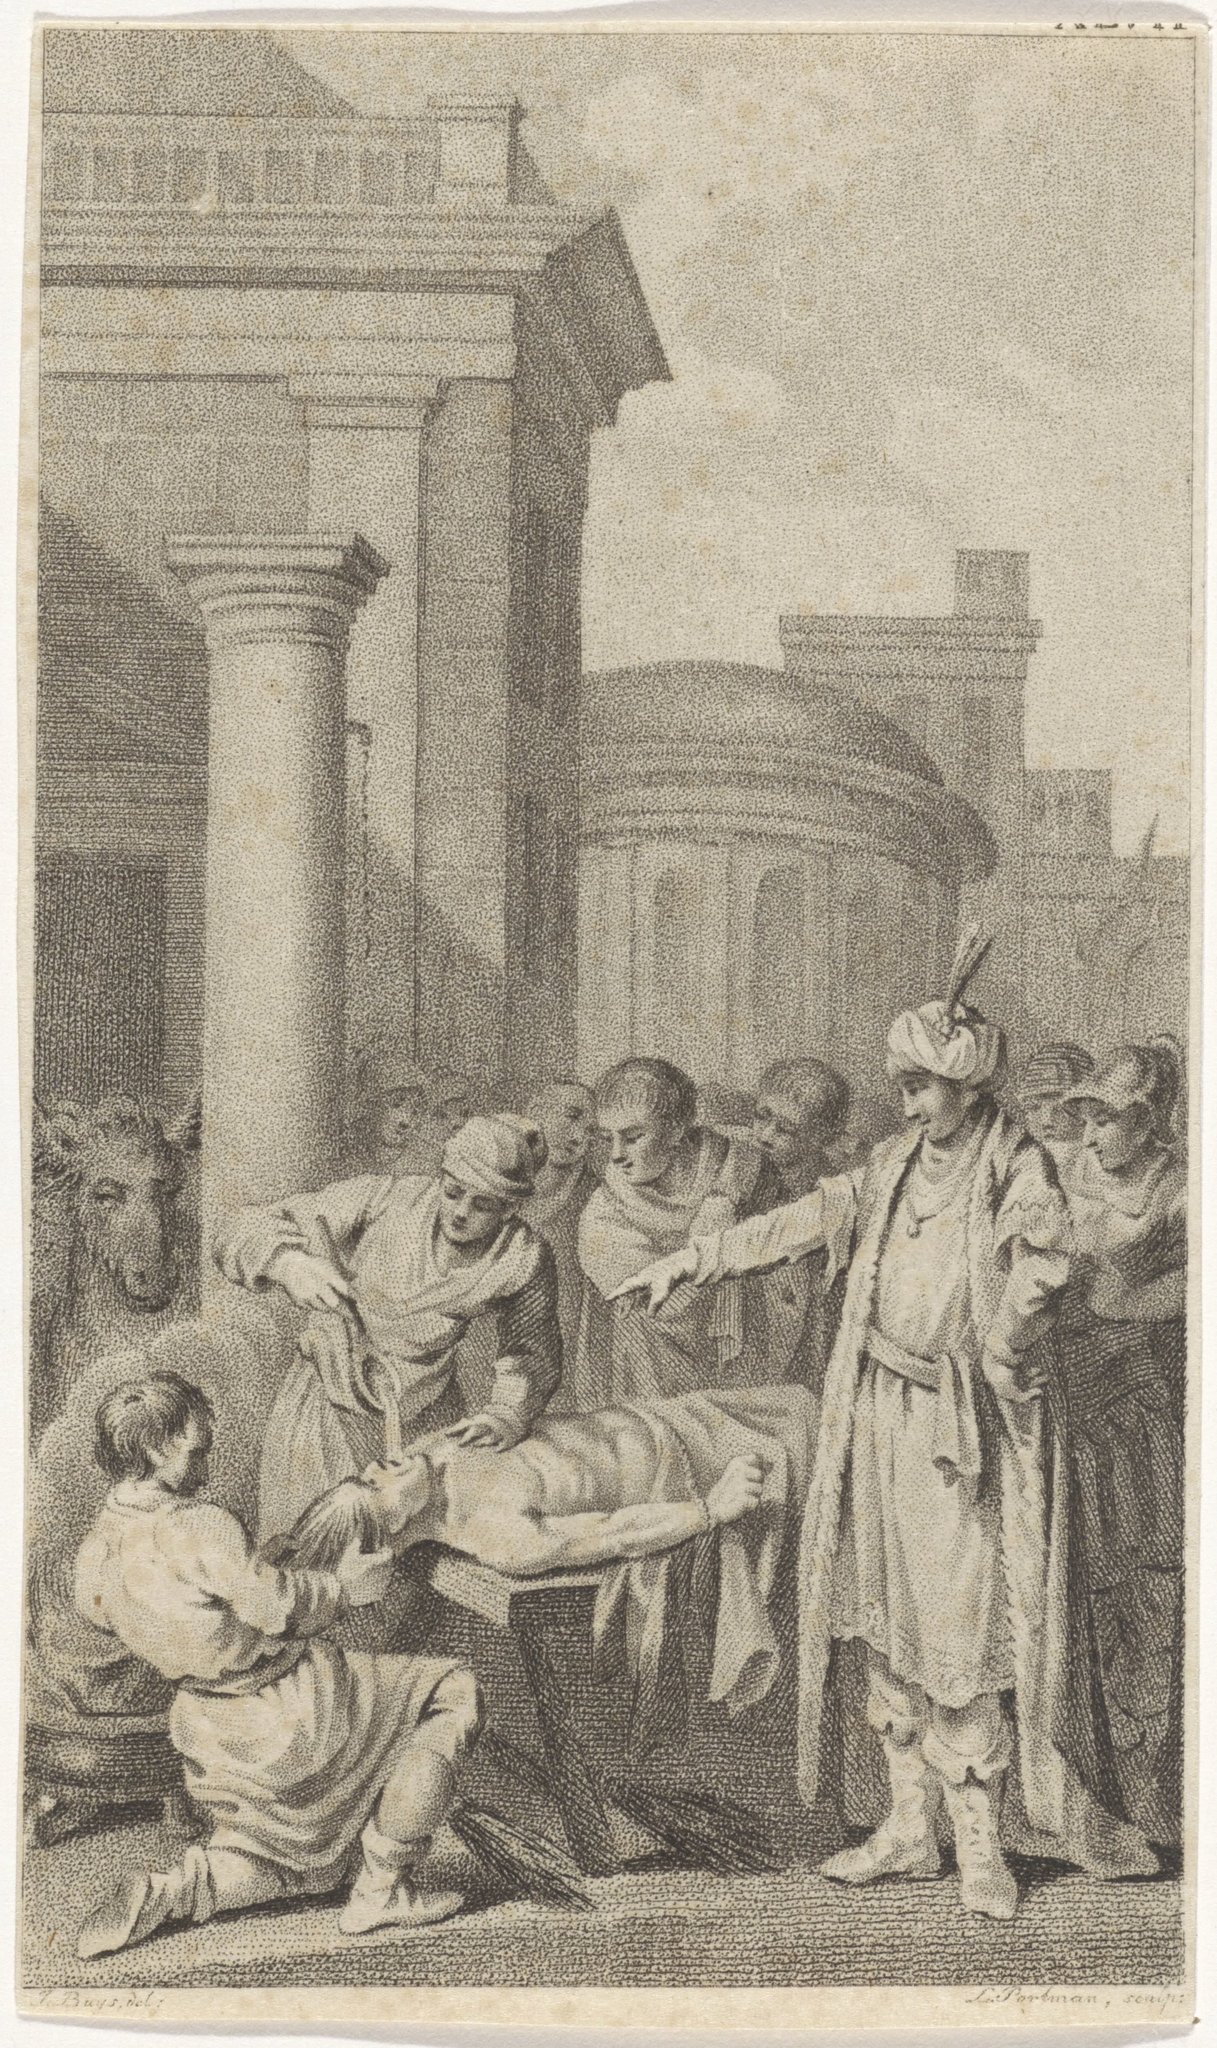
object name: book illustration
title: Dood van Manius Aquillius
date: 1798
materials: paper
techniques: etching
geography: amsterdam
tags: male persons from classical history (aquilius, m.) - death of person from classical history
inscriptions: collector's mark: Lugt 2228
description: De gruwelijke dood van de Romeinse consul Manius Aquillius bij het theater van Dionysus. Mannen gieten gesmolten goud in zijn mond.